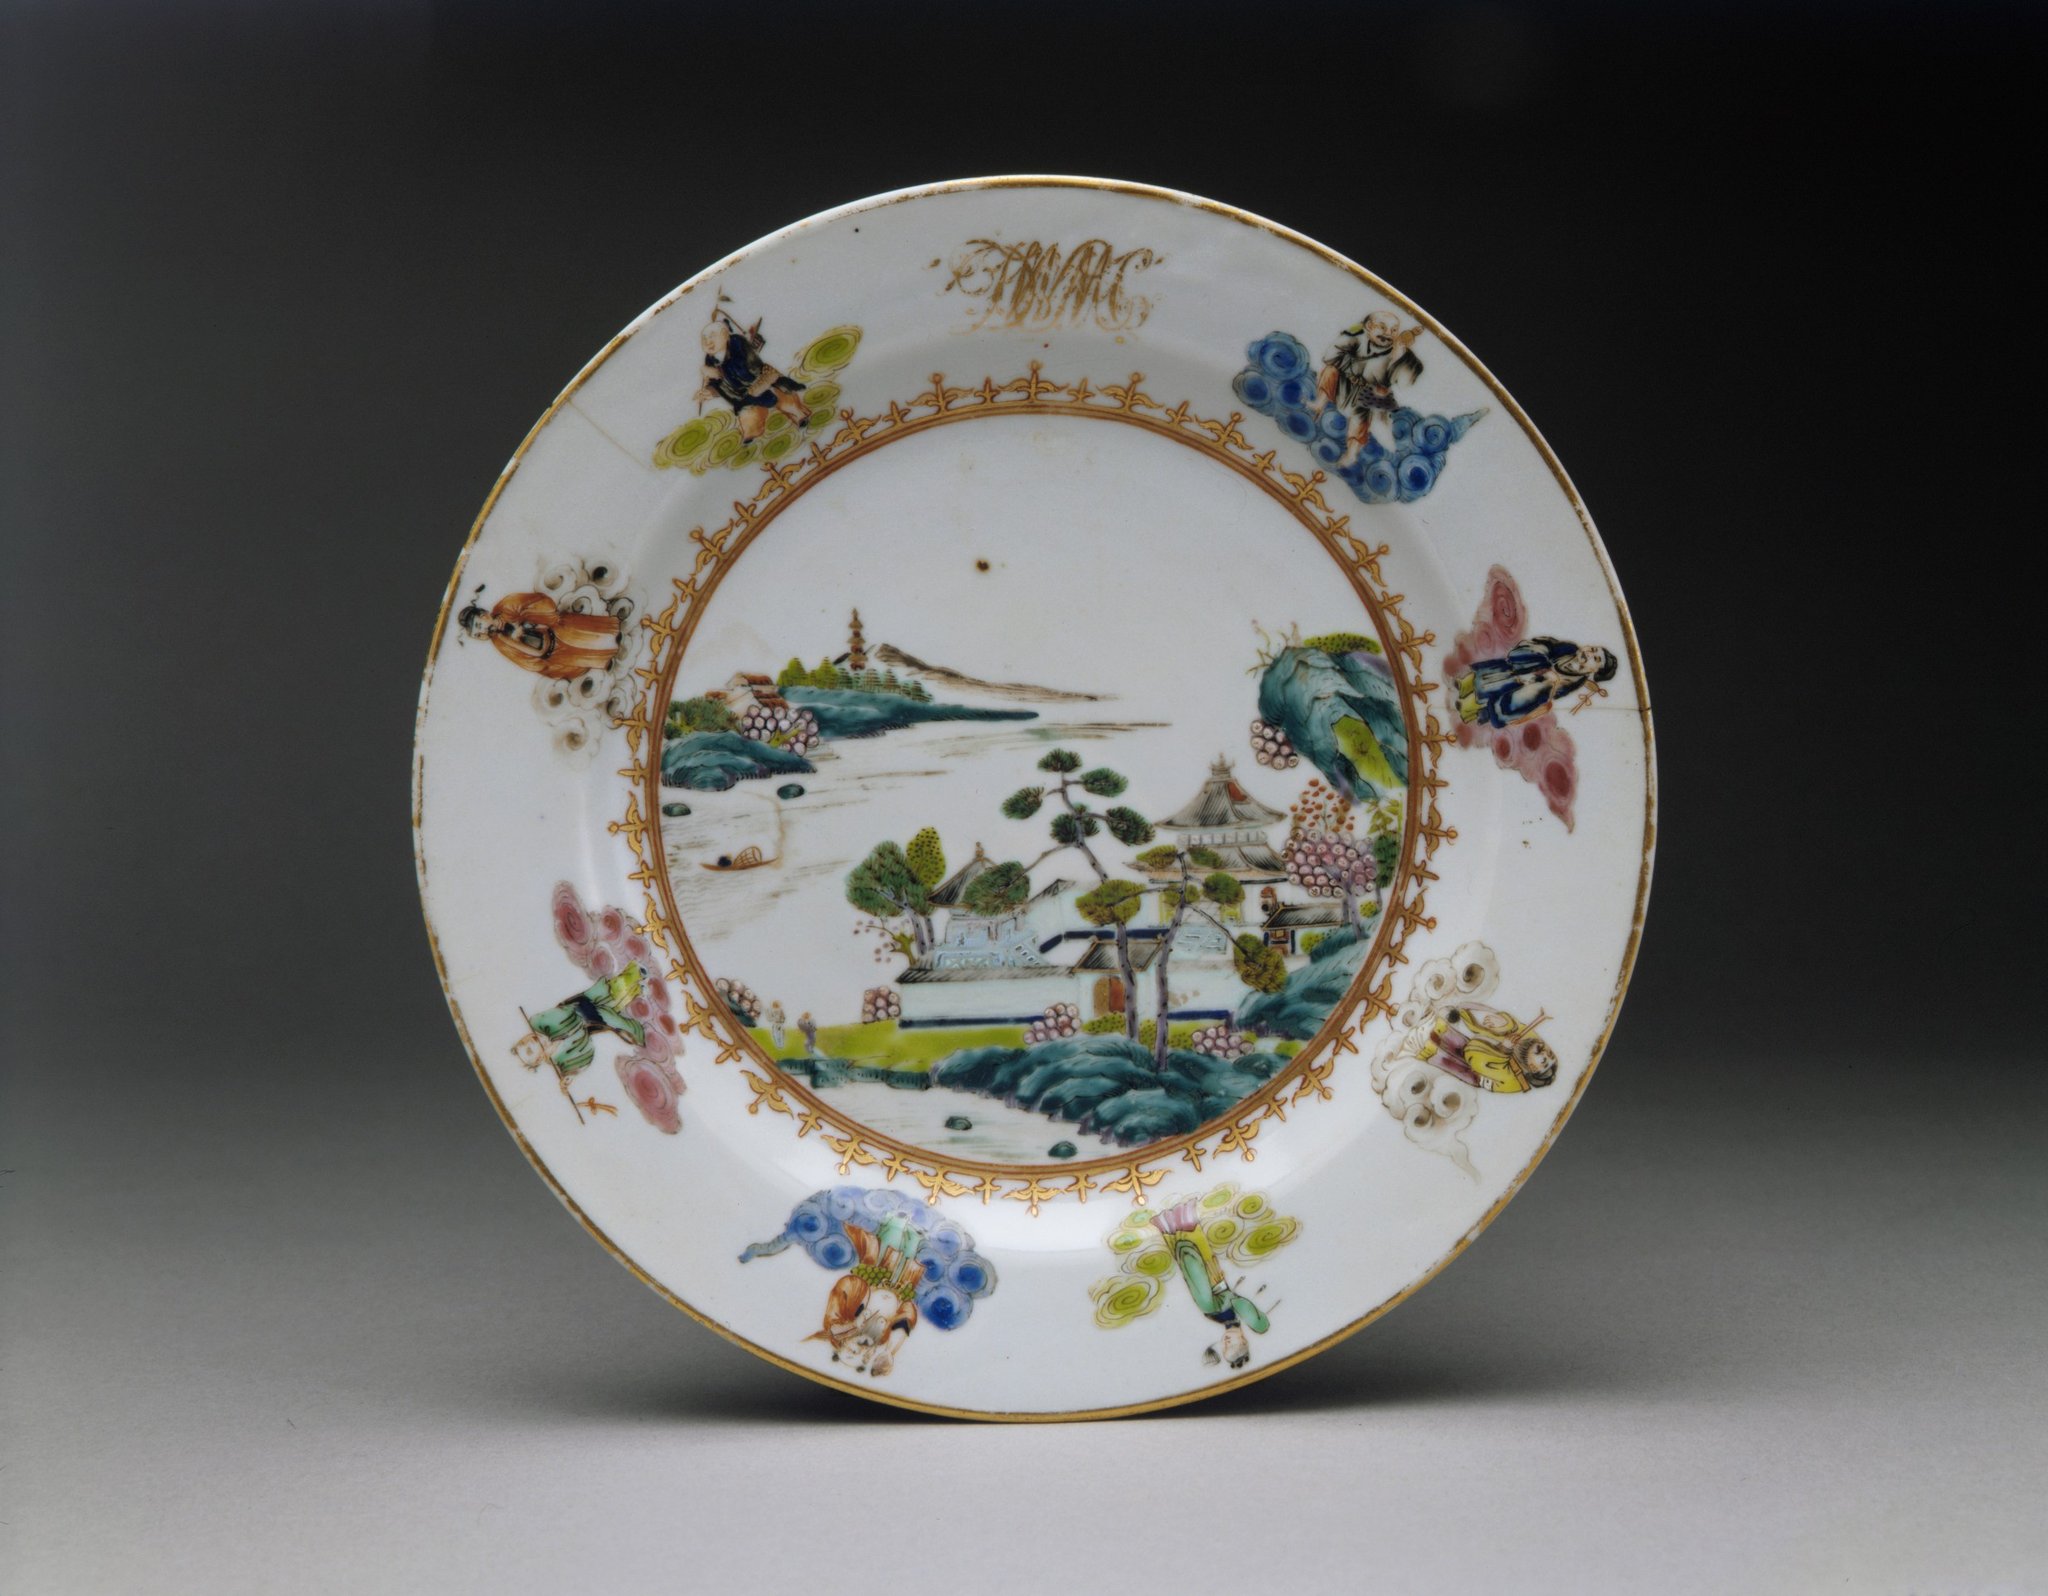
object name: dinner plate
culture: chinese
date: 1796-1810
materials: porcelain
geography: china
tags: men,landscapes